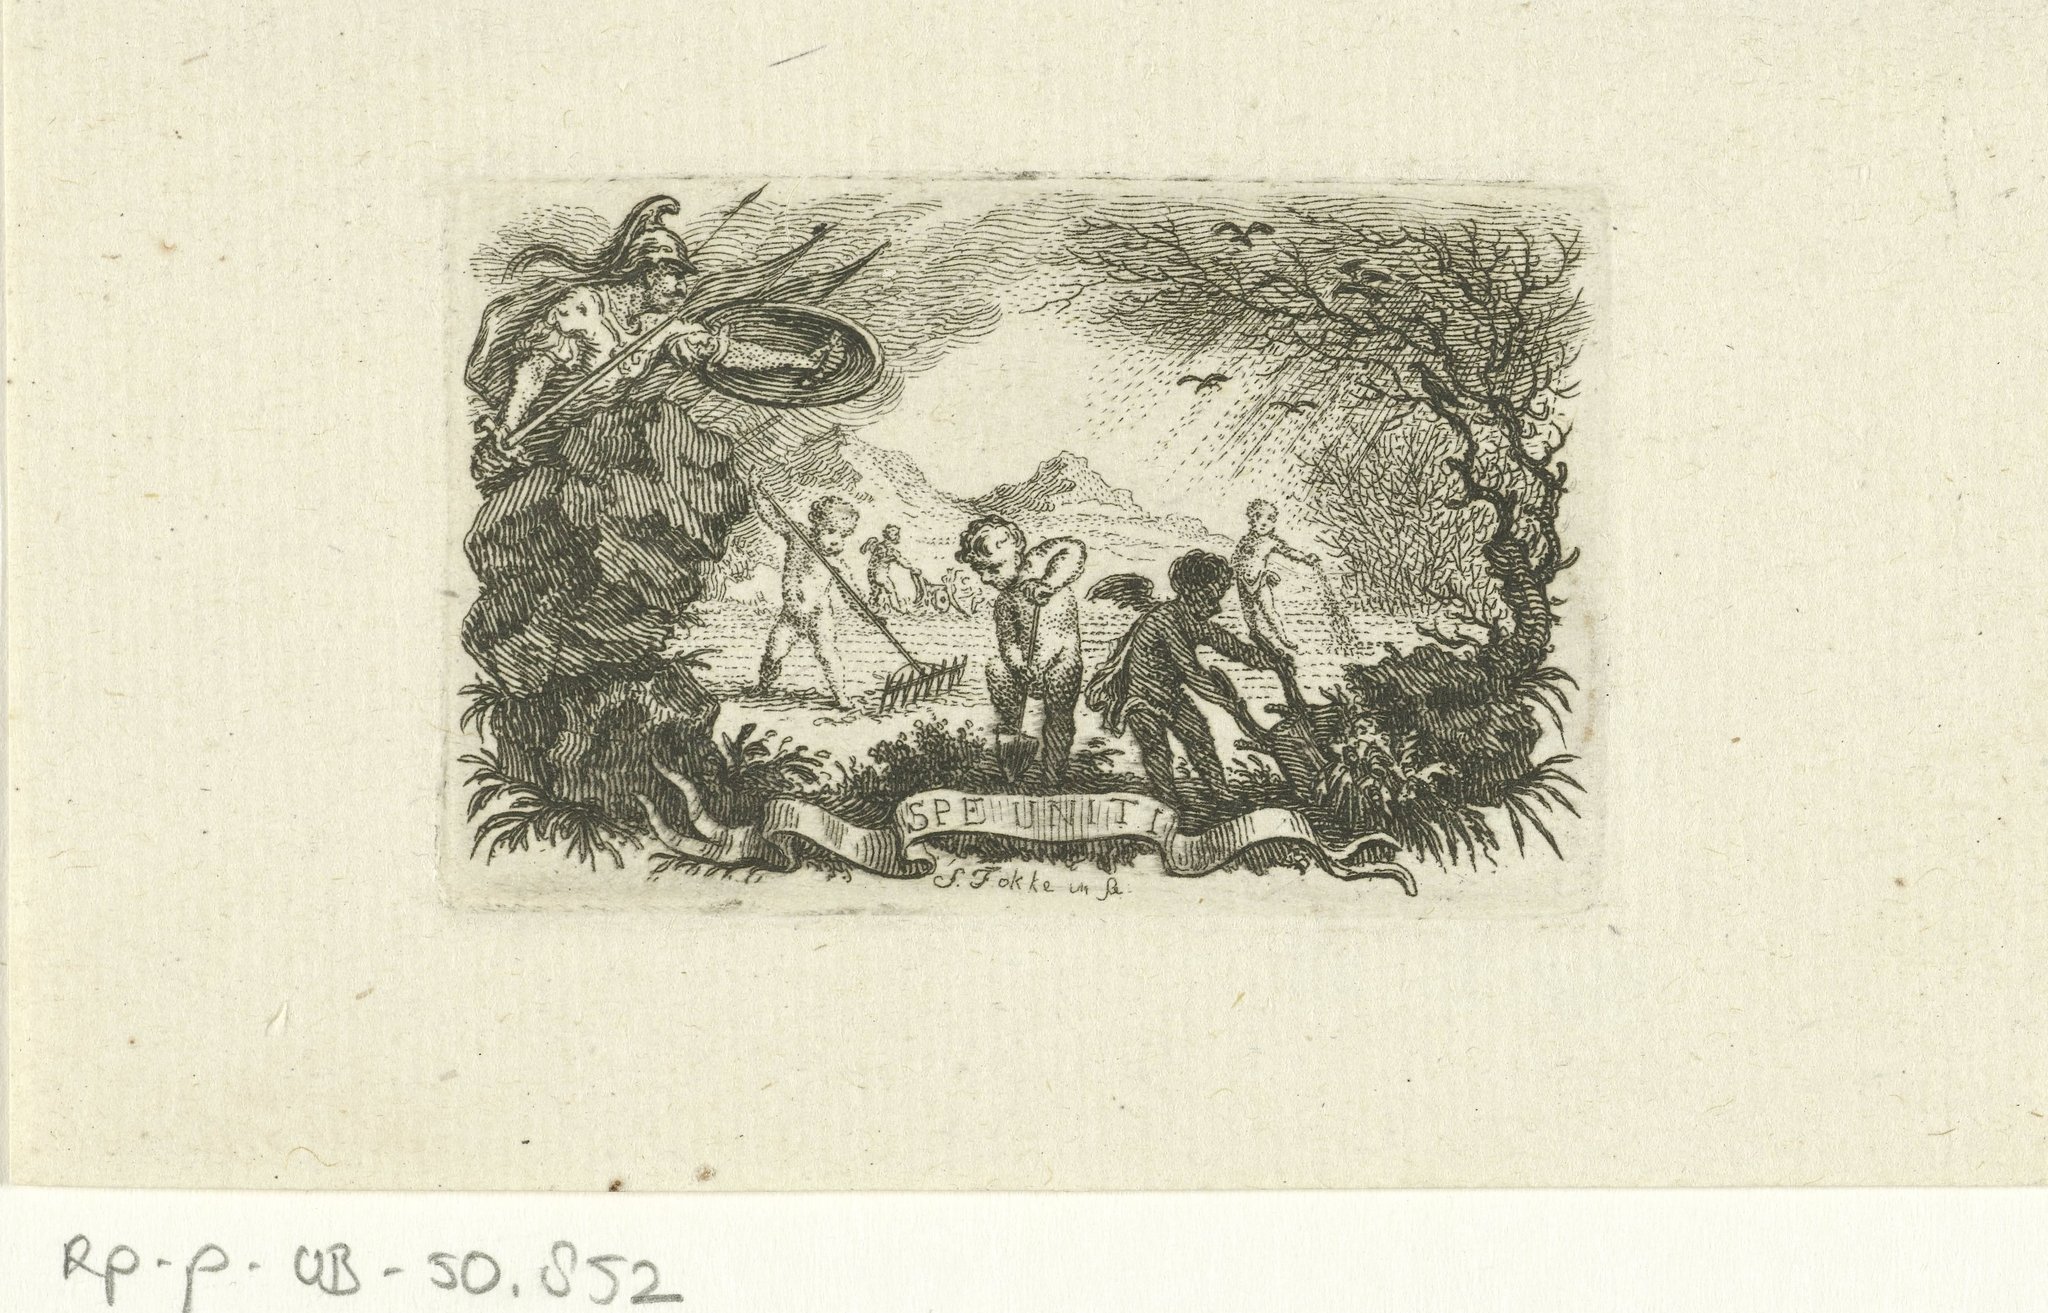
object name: print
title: Mars doemt op bij op het land werkende putti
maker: simon fokke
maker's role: draughtsman, print maker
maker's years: 1712-1784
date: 1722-1783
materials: paper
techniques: etching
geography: amsterdam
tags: (story of) mars (ares), cupids: 'amores', 'amoretti', 'putti'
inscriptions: collector's mark: Lugt 240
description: Mars doemt op bij putti die op het land aan het werk zijn. Op een banderol onderaan de voorstelling de tekst: Spe Uniti.